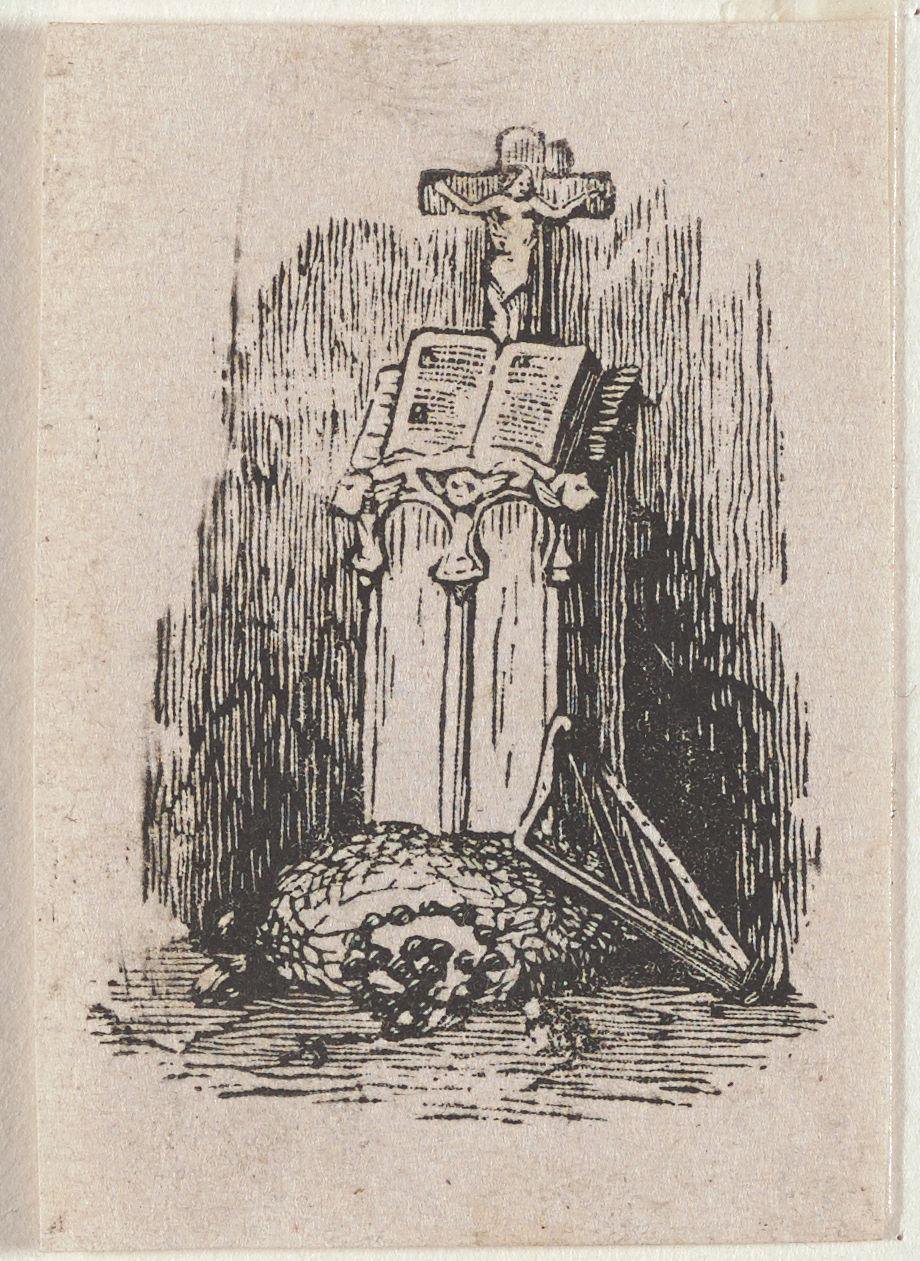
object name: print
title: Lessenaar met een opengeslagen boek, een crucifix en een harp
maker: isaac weissenbruch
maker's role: print maker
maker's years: 1826-1912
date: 1836-1912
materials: paper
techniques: engraving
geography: netherlands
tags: altarcross, crucifix, harp, book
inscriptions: collector's mark: Lugt 2228